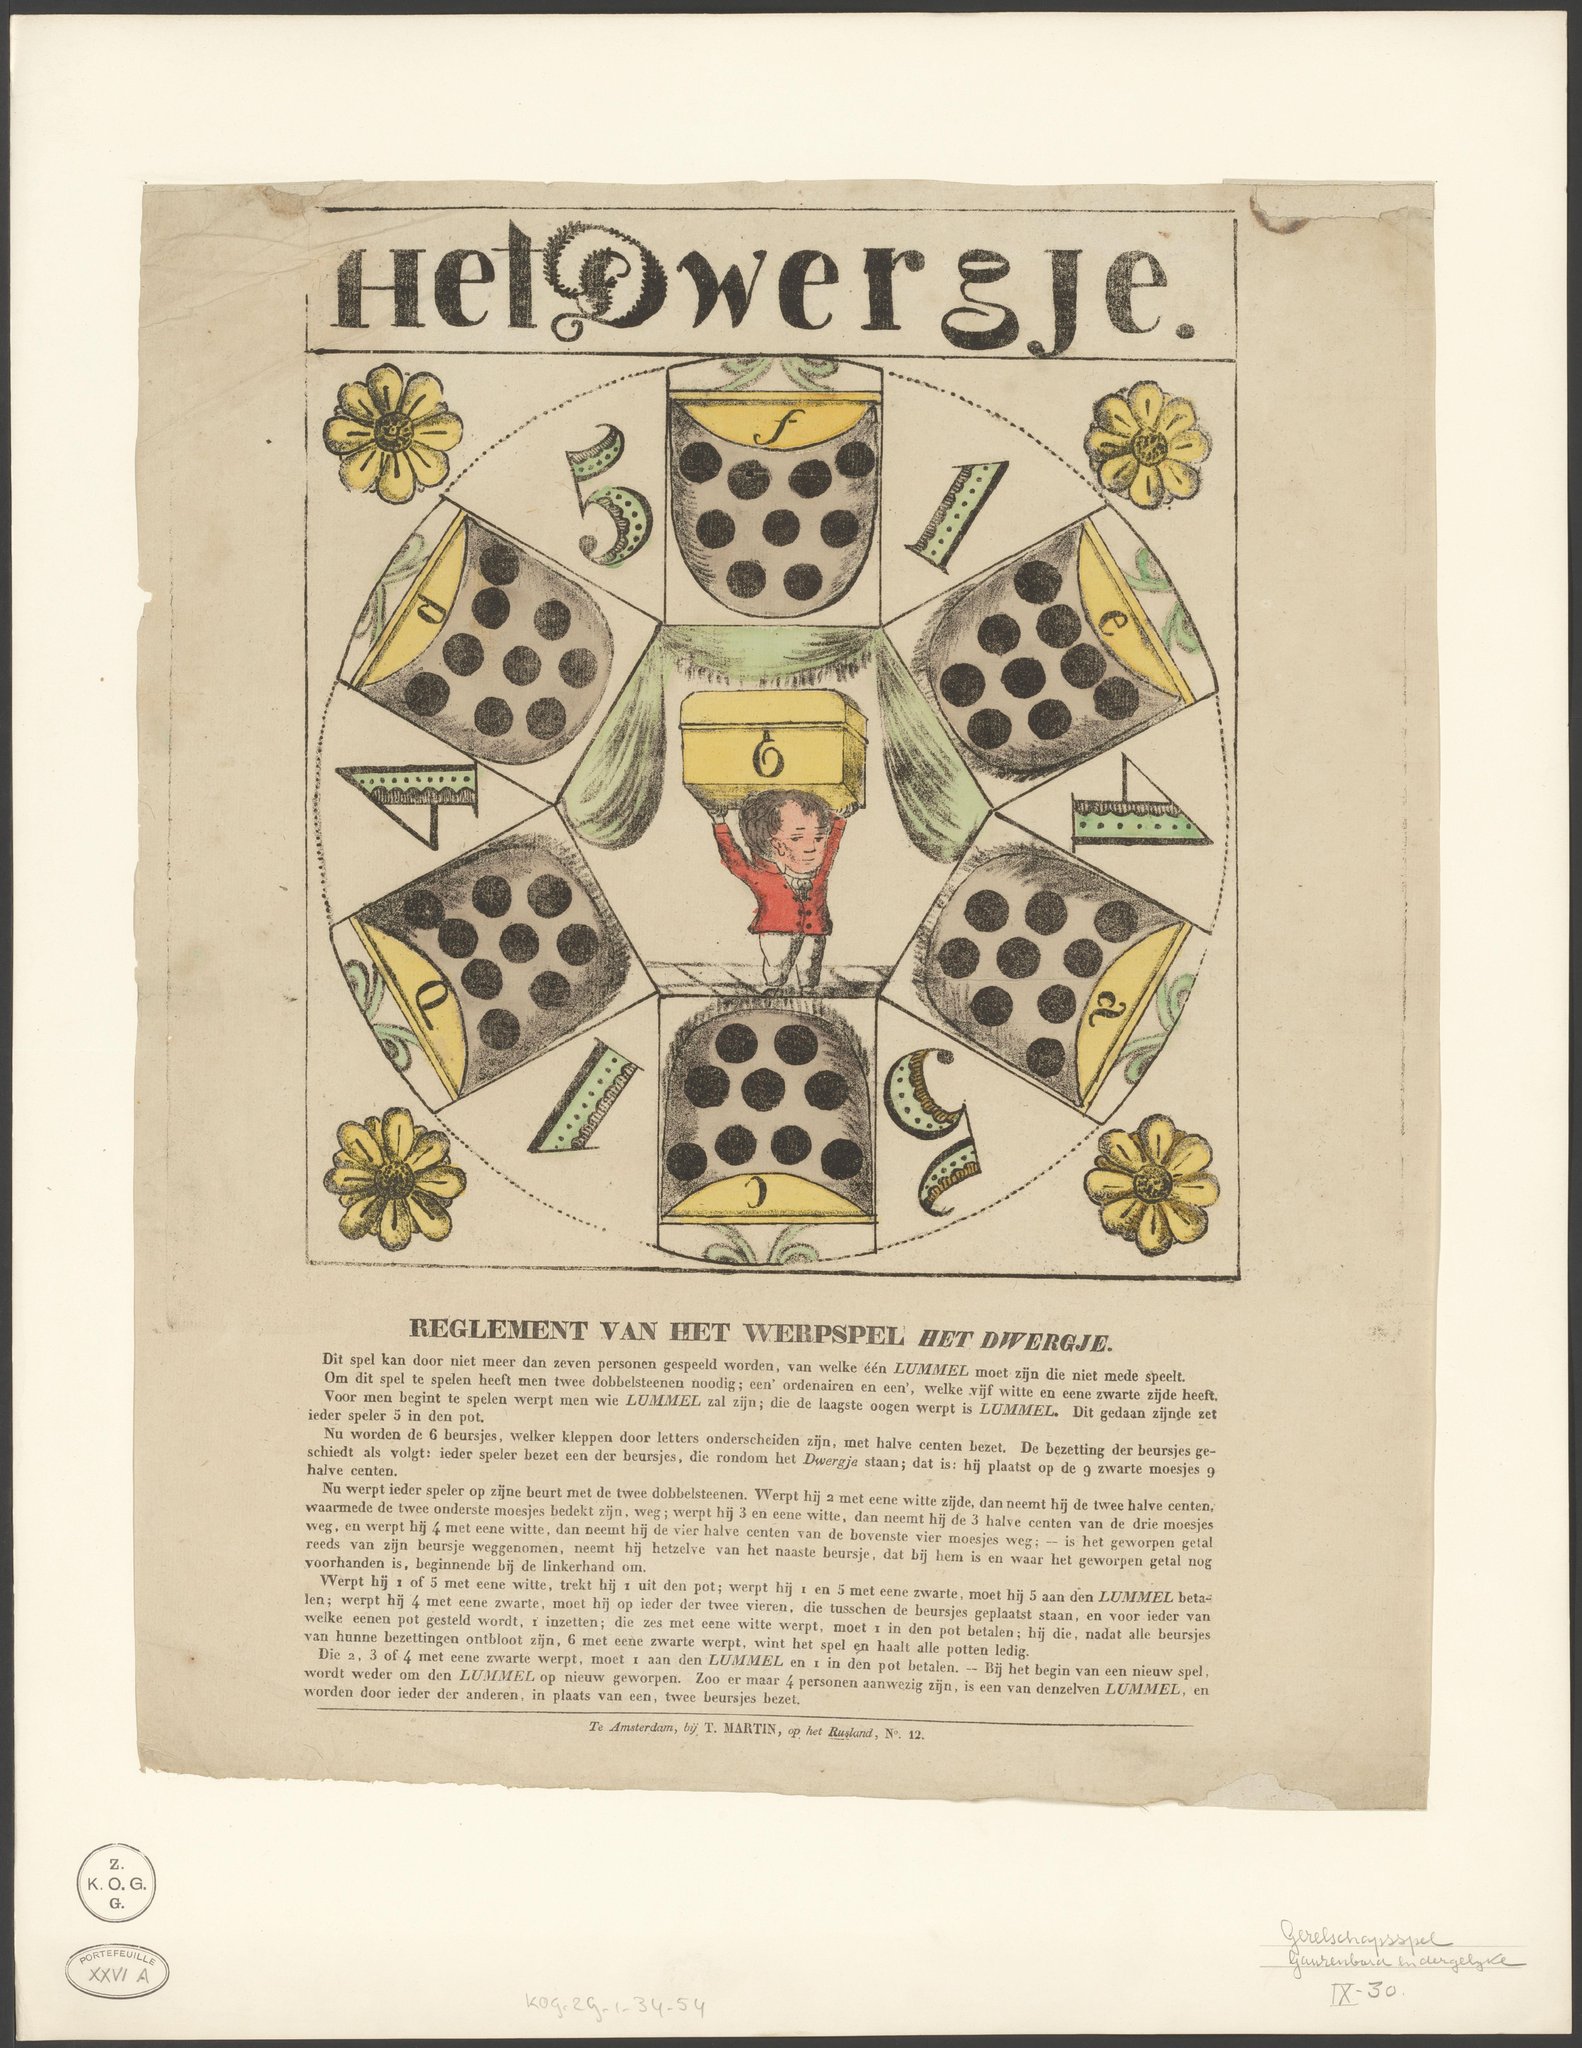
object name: print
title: Het Dwergje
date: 1827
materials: paper, watercolor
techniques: hand coloring, letterpress printing, lithograph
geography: amsterdam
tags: board-games of chance, little people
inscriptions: collector's mark, collector's mark: Lugt 1641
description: Een werpspel met in het midden van een cirkel een kleine mens met op zijn hoofd een geldkist. Rondom zes beursjes met stippen. Onder het spel op hetzelfde blad het 'Reglement van het werpspel Het Dwergje.' Onderwerpsrubrieken binnen de Atlas Zeden en Gewoonten: Spel en Vermaak; gezelschapsspel, ganzenbord en dergelijke.